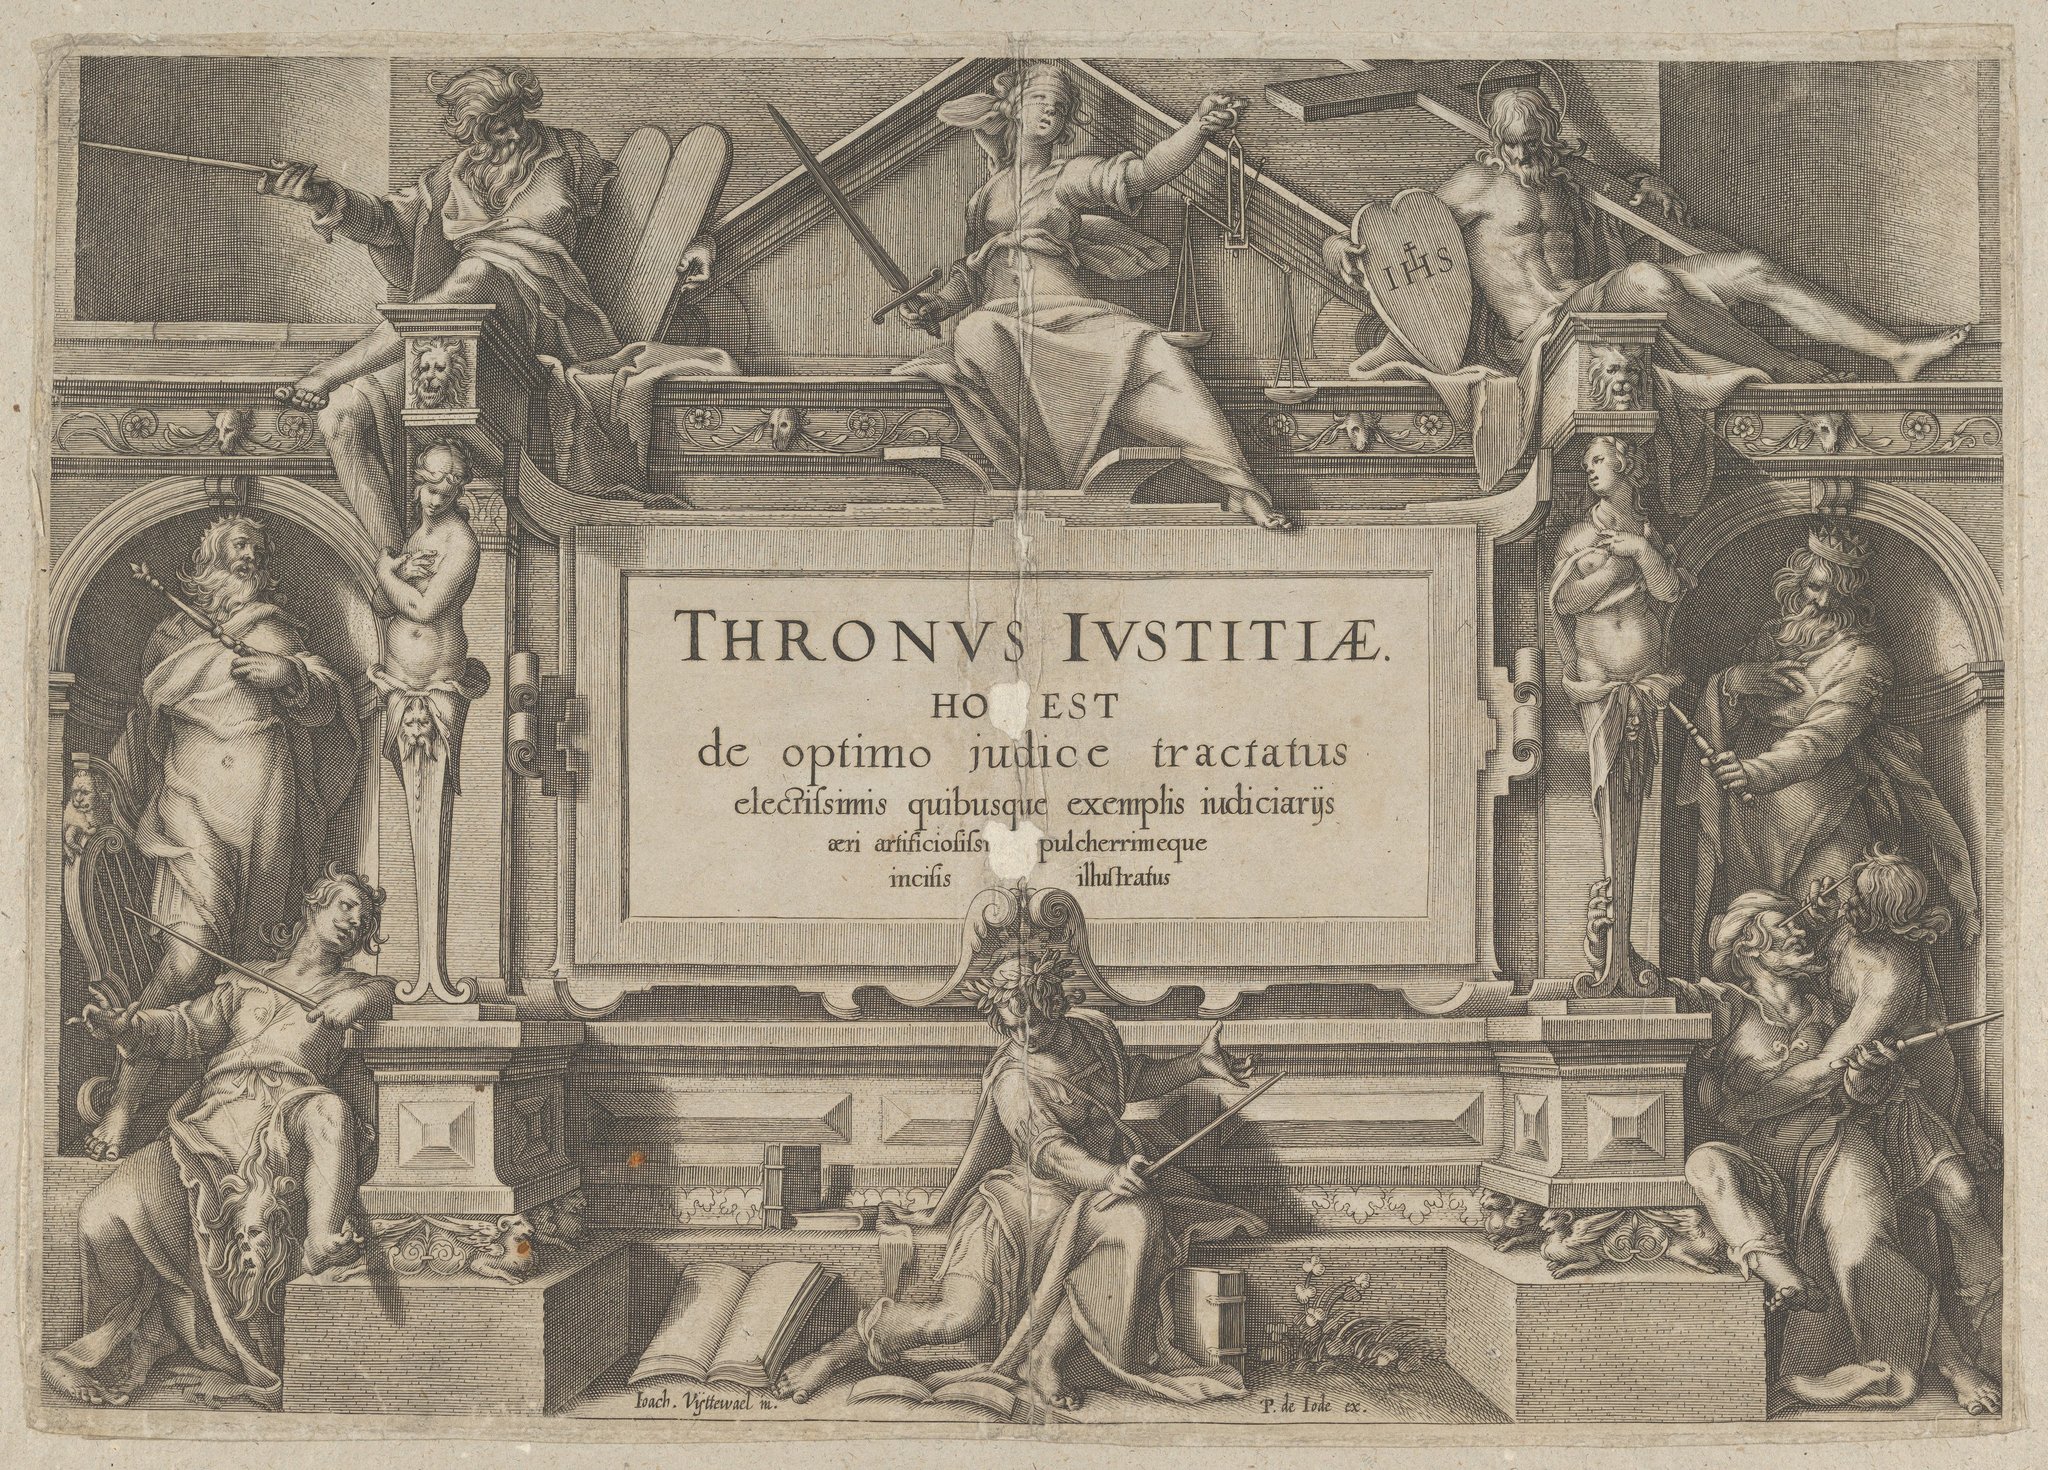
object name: print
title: Title Page Set in an Architectural Frame with Allegorical figures and Christ, from "Thronus Justitiae, tredecim pulcherrimus tabulis..."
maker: willem van swanenburg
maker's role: artist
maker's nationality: netherlandish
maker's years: 1581-1612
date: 1605-1606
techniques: engraving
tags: swords,men,women,christ